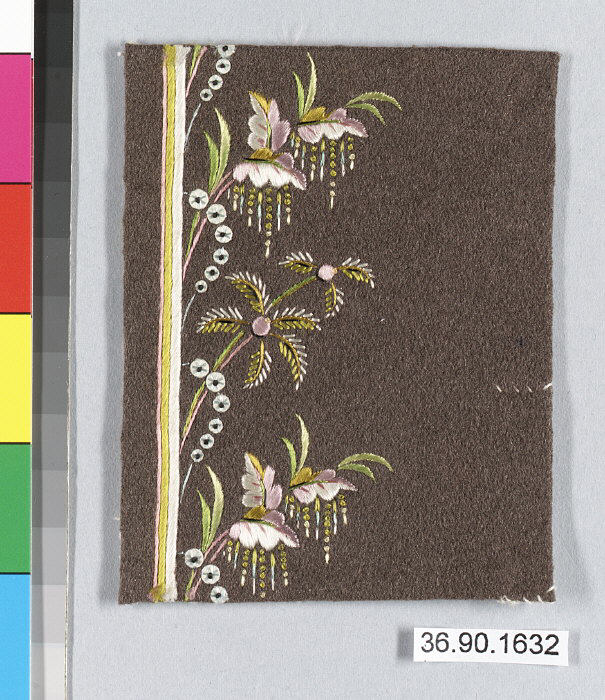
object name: sample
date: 1801-1833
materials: silk, wool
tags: plants